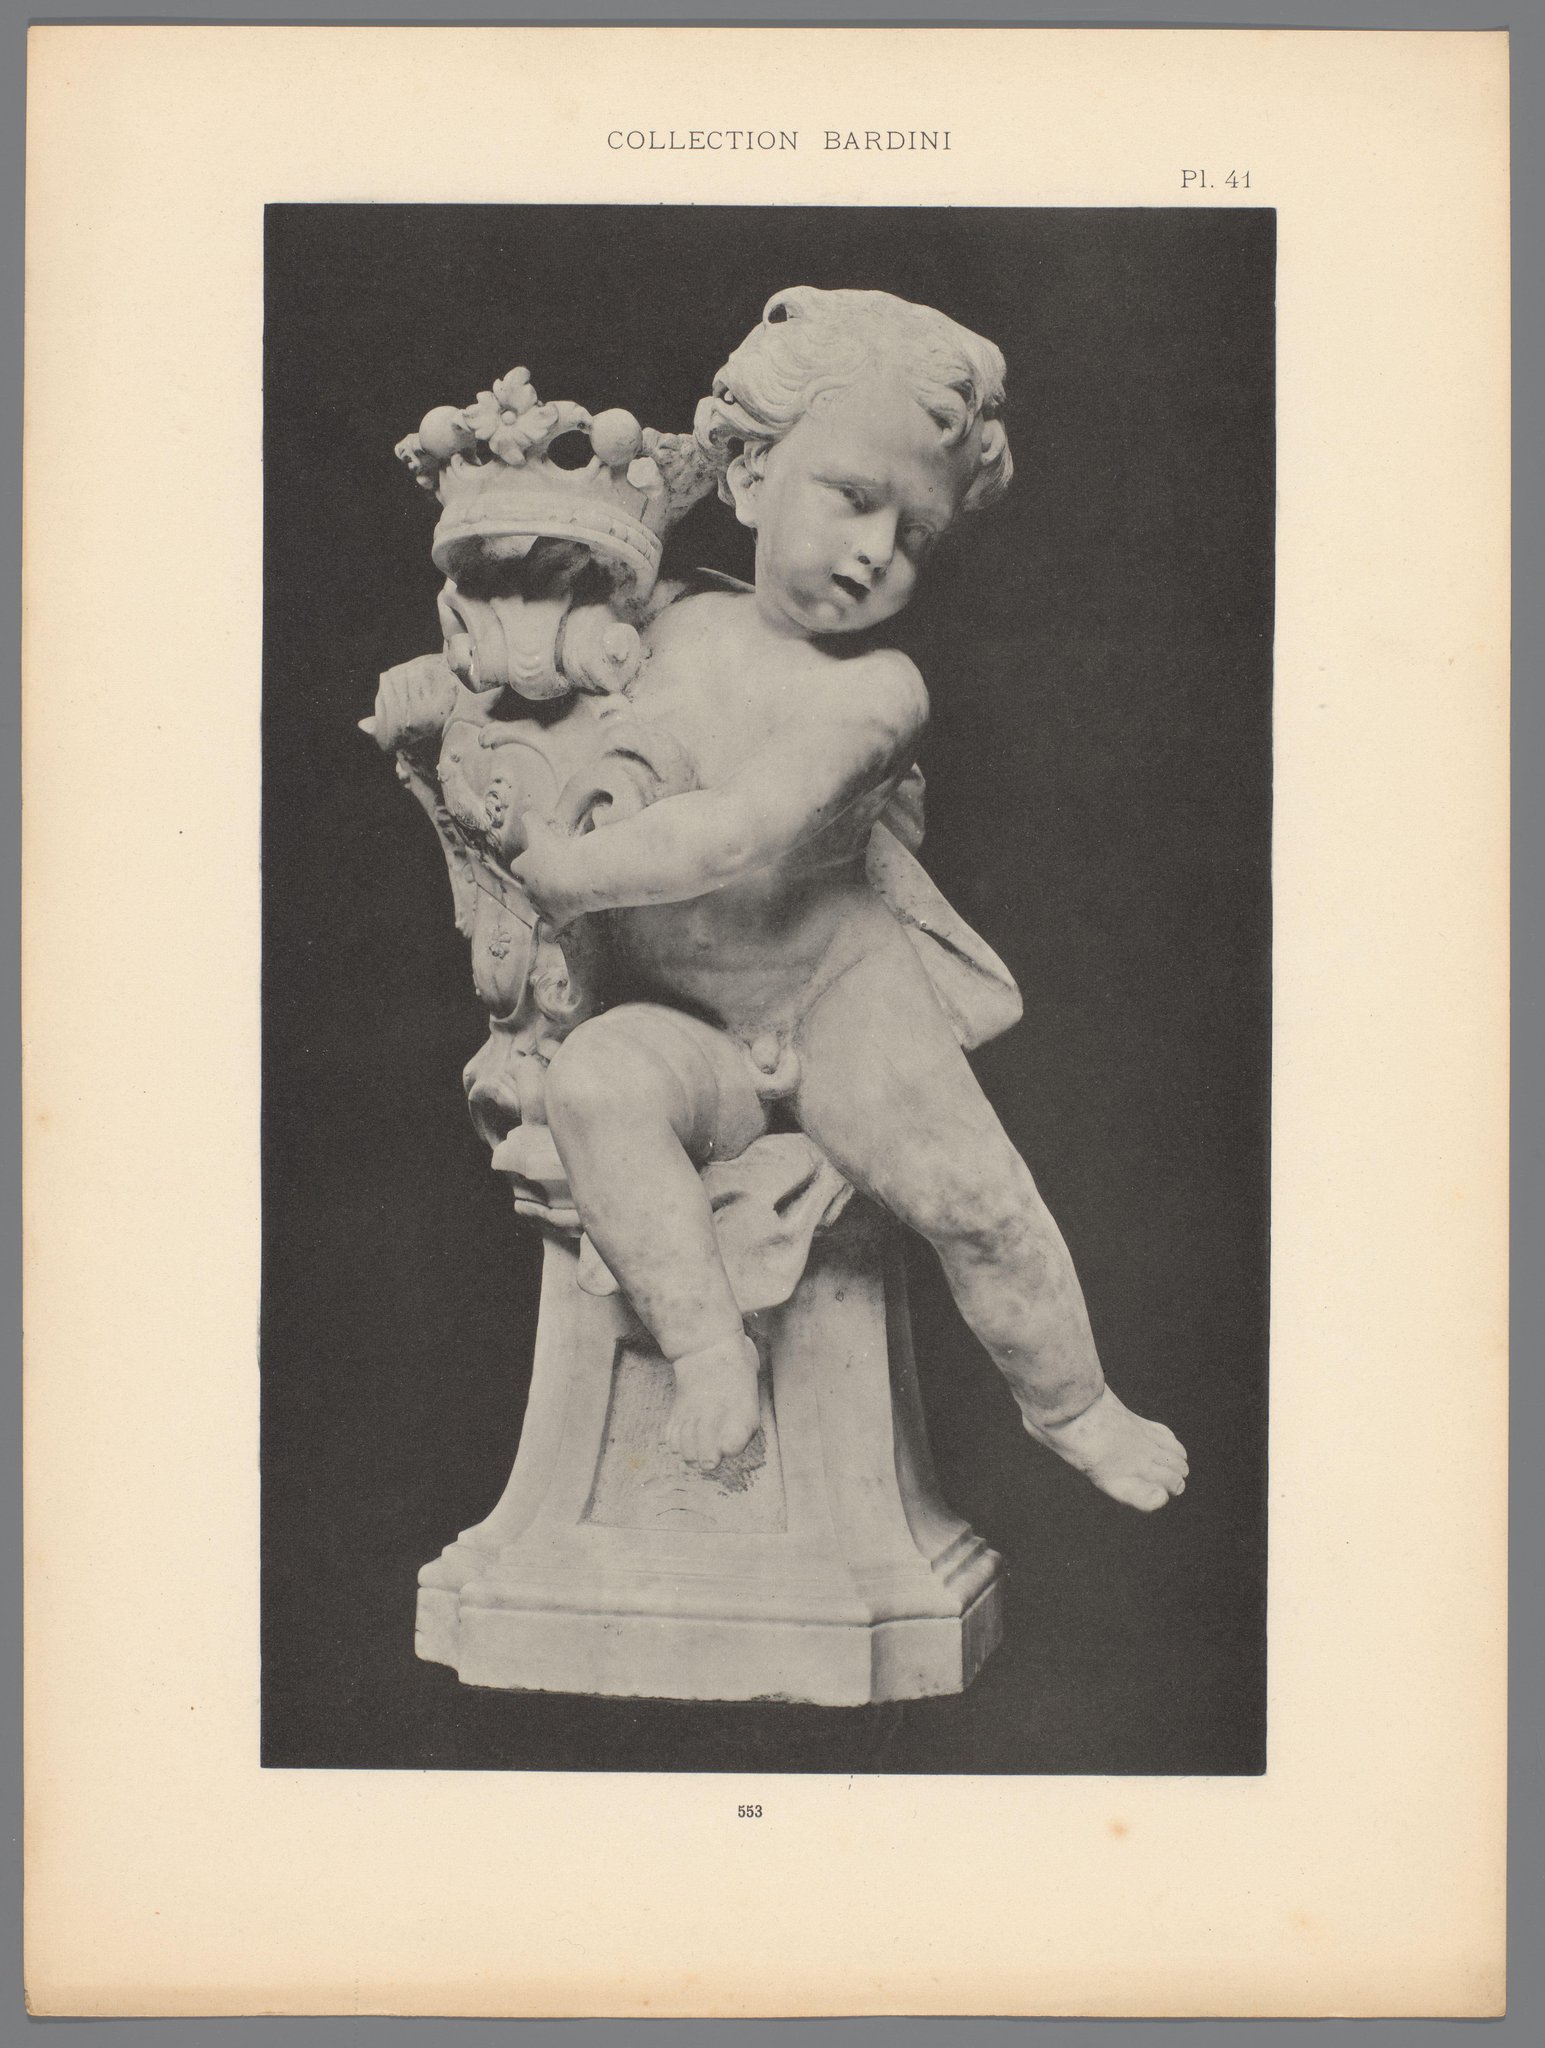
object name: photomechanical print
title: Sculptuur van een kind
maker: Anonymous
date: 1875-1930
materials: paper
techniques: photograph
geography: florence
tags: child, sculpture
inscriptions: number: ‘Pl. 41’